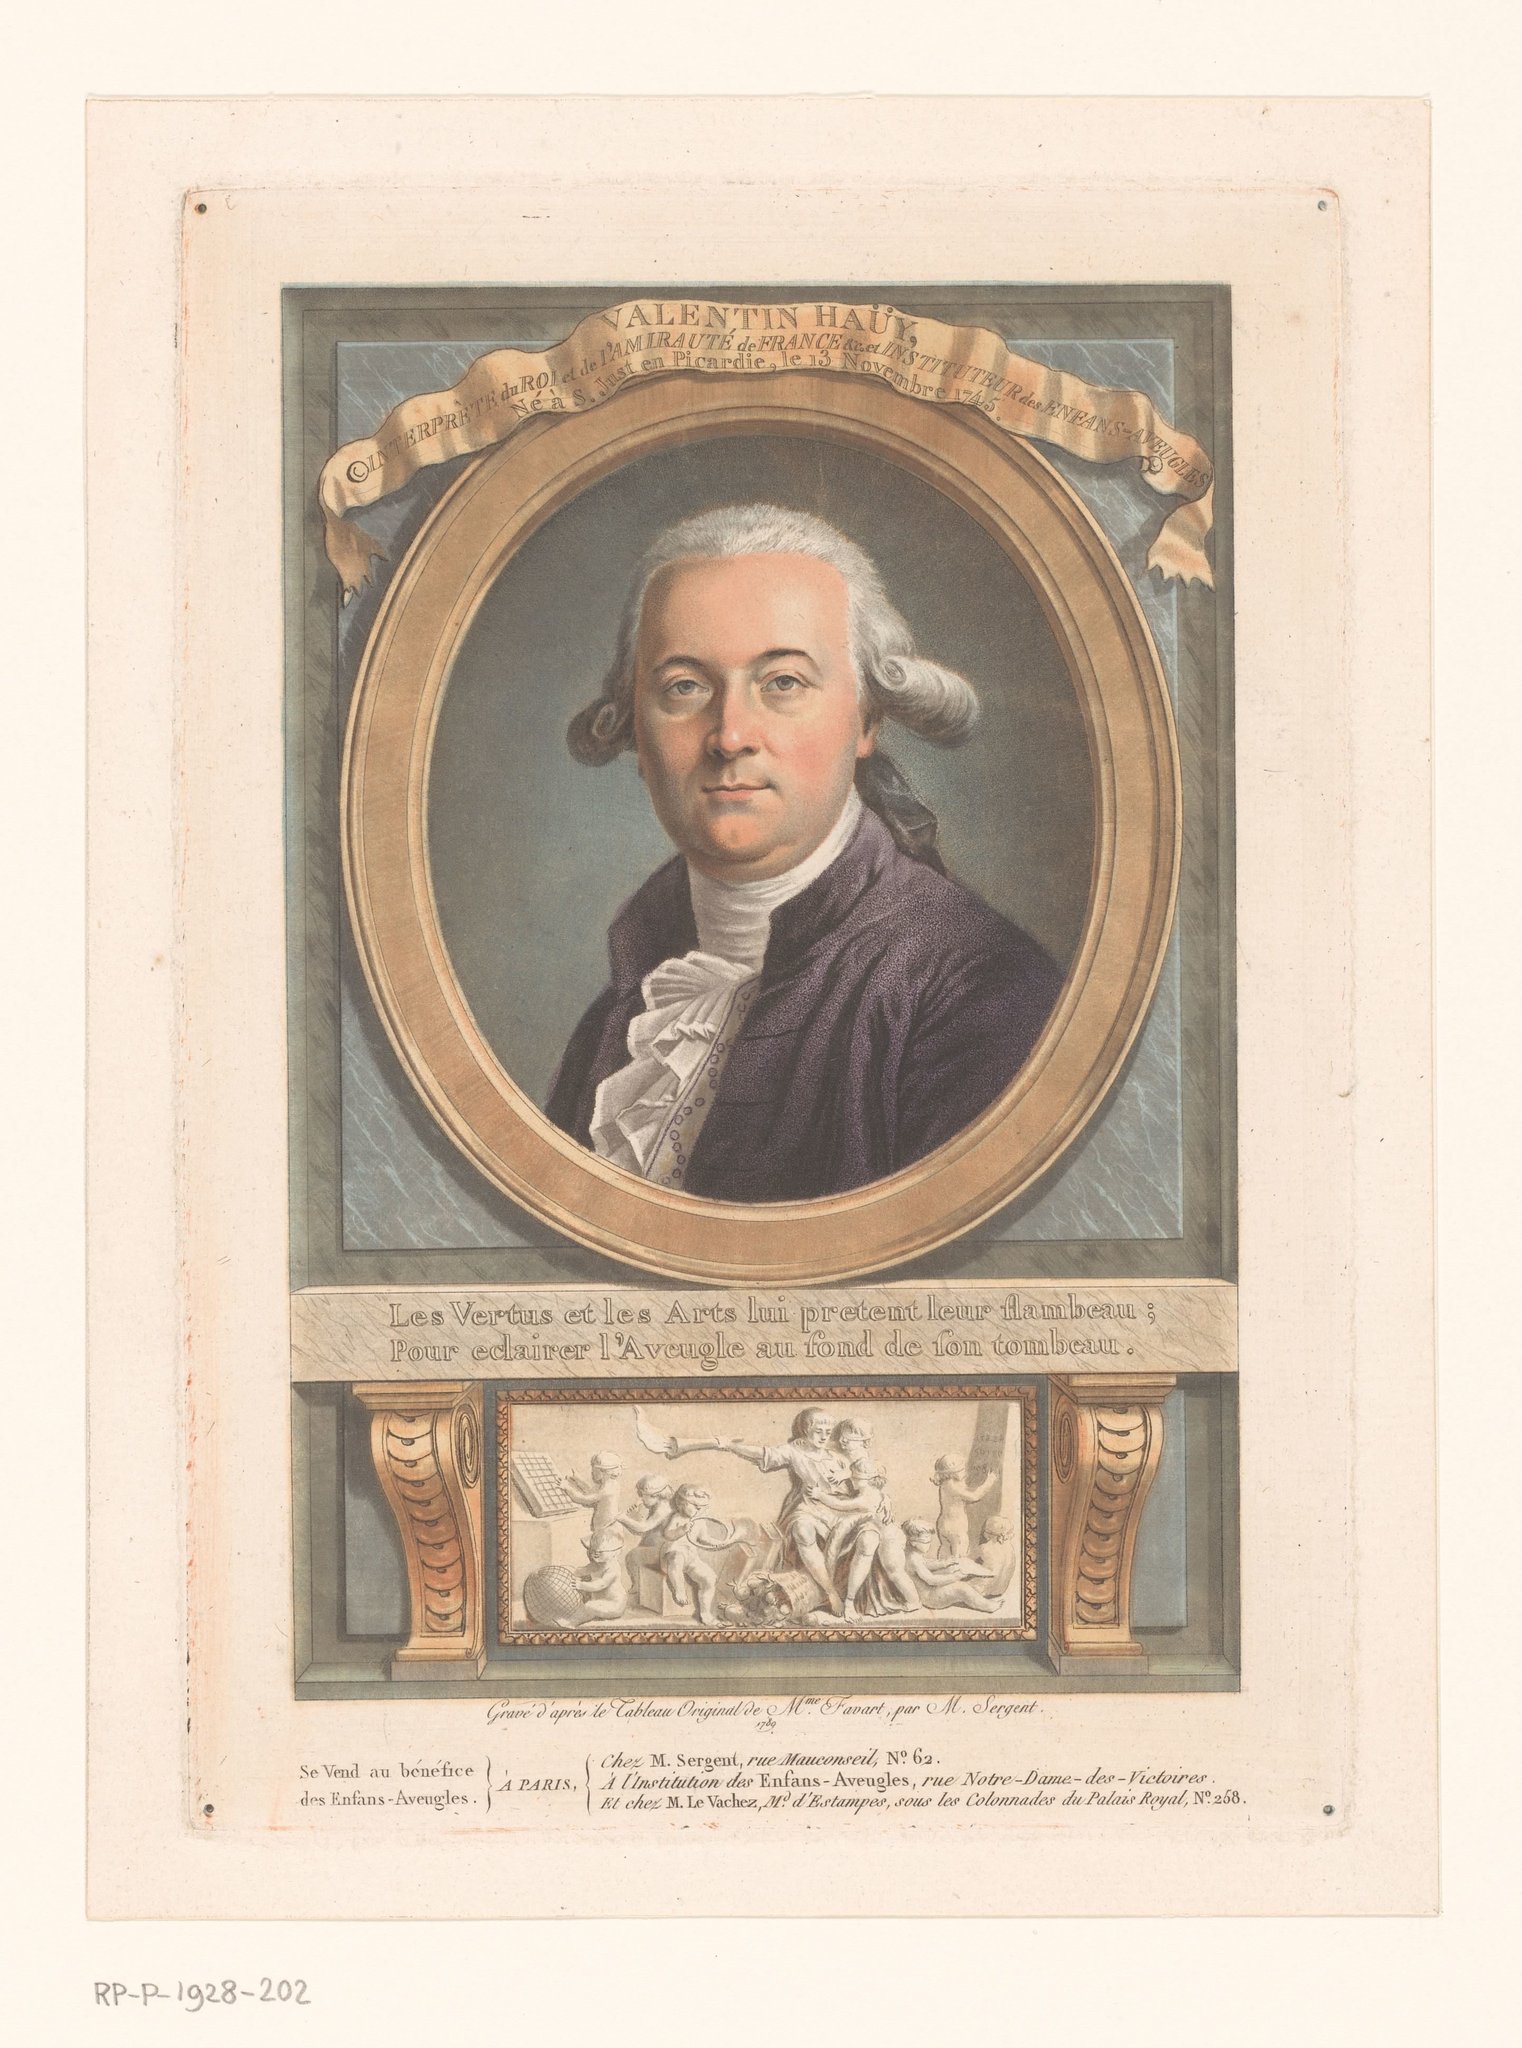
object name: print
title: Portret van Valentin Haüy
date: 1789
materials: paper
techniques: aquatint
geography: paris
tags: paris, scholar, philosopher, historical persons, blind, blindness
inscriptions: collector's mark: Lugt 2228